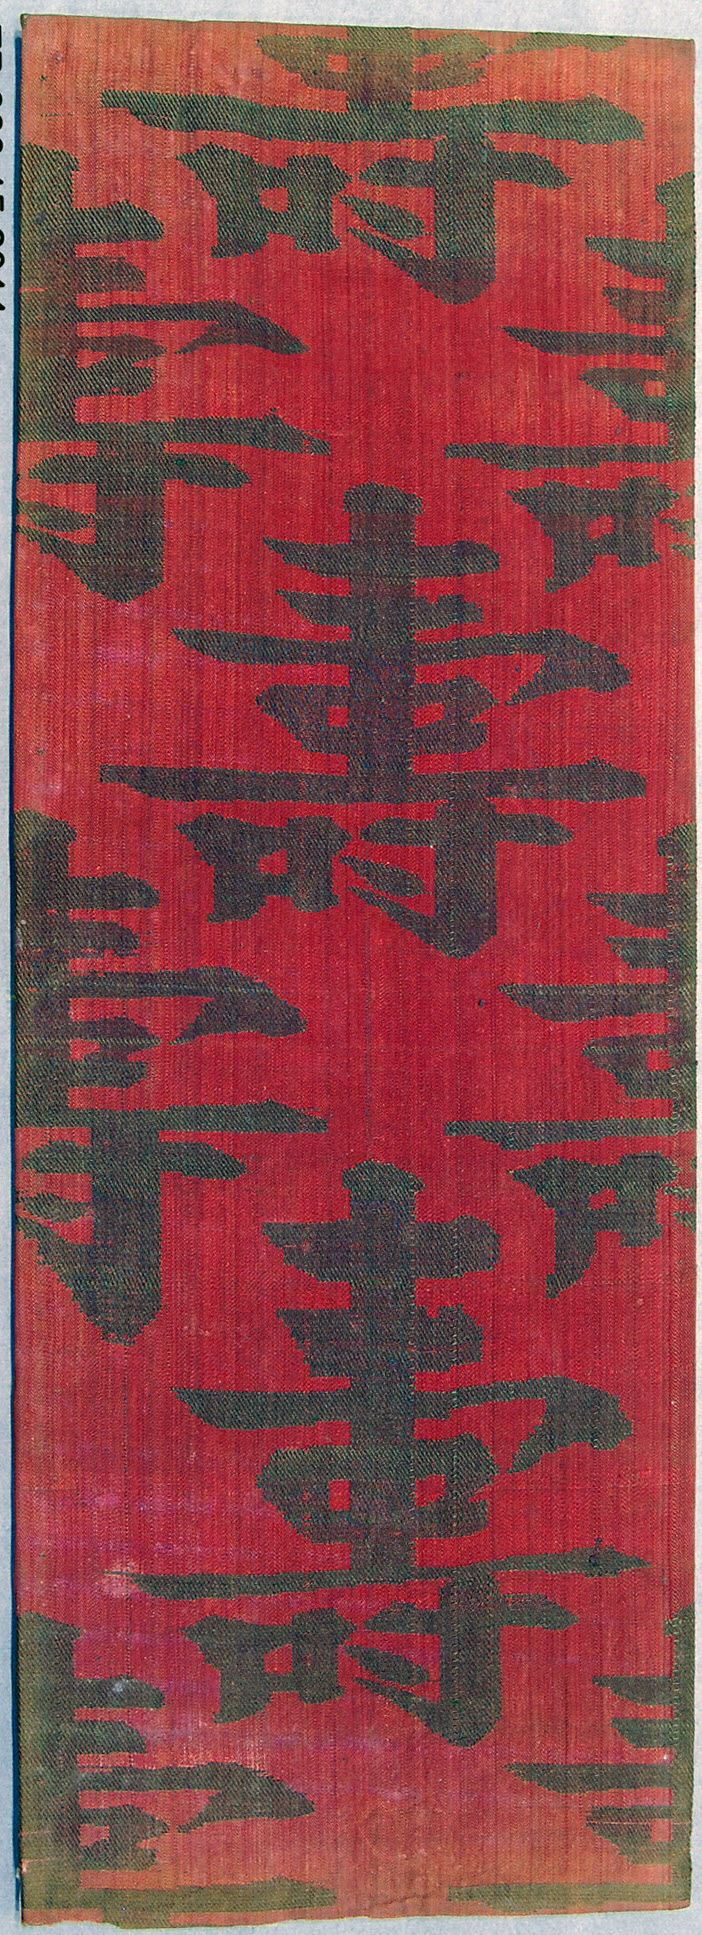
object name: sutra cover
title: Sutra Cover with the Chinese Character Shou (Longevity)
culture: chinese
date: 1501-1600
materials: silk